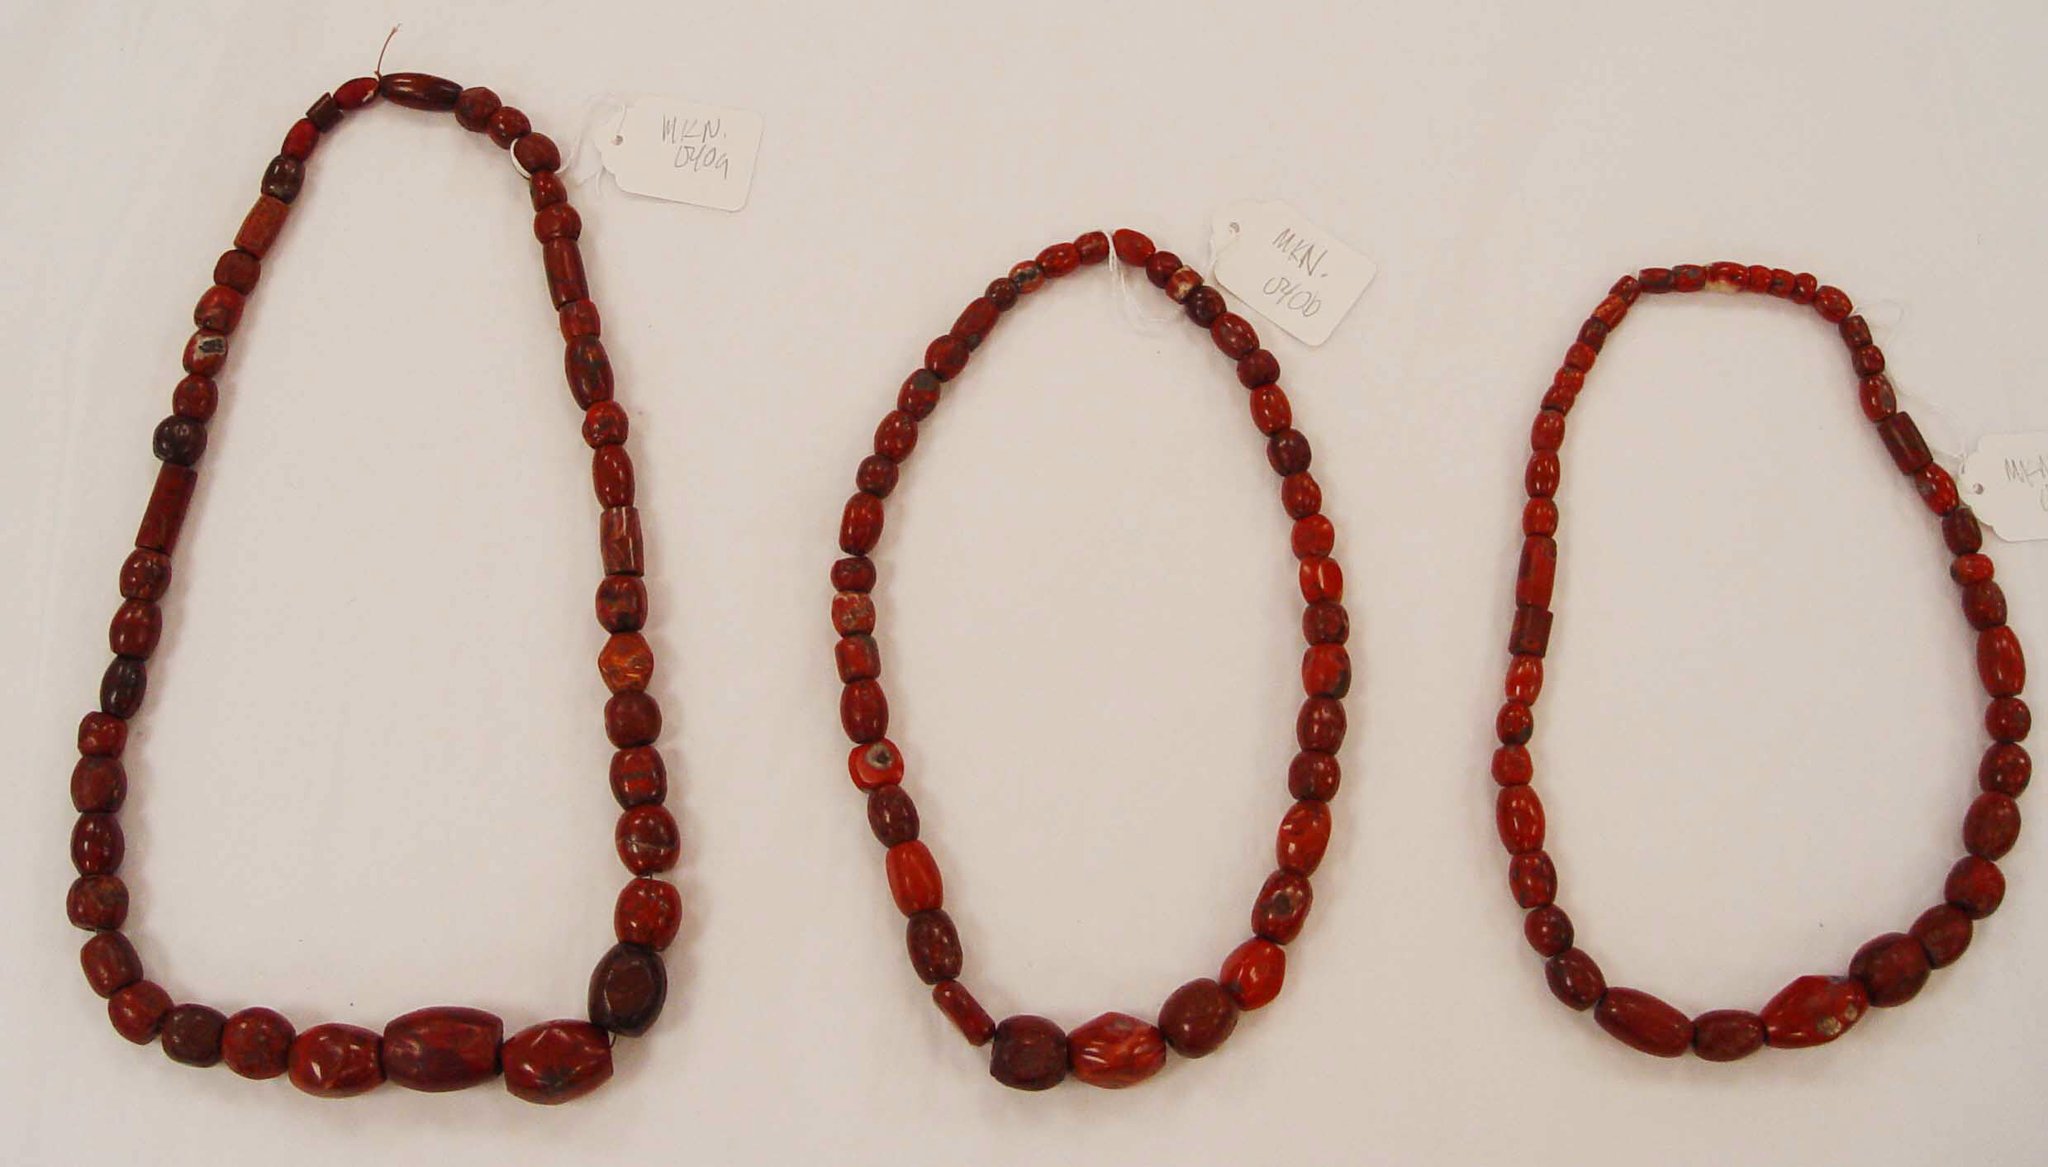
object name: jewelry set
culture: naga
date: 1801-1900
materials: cotton, stone